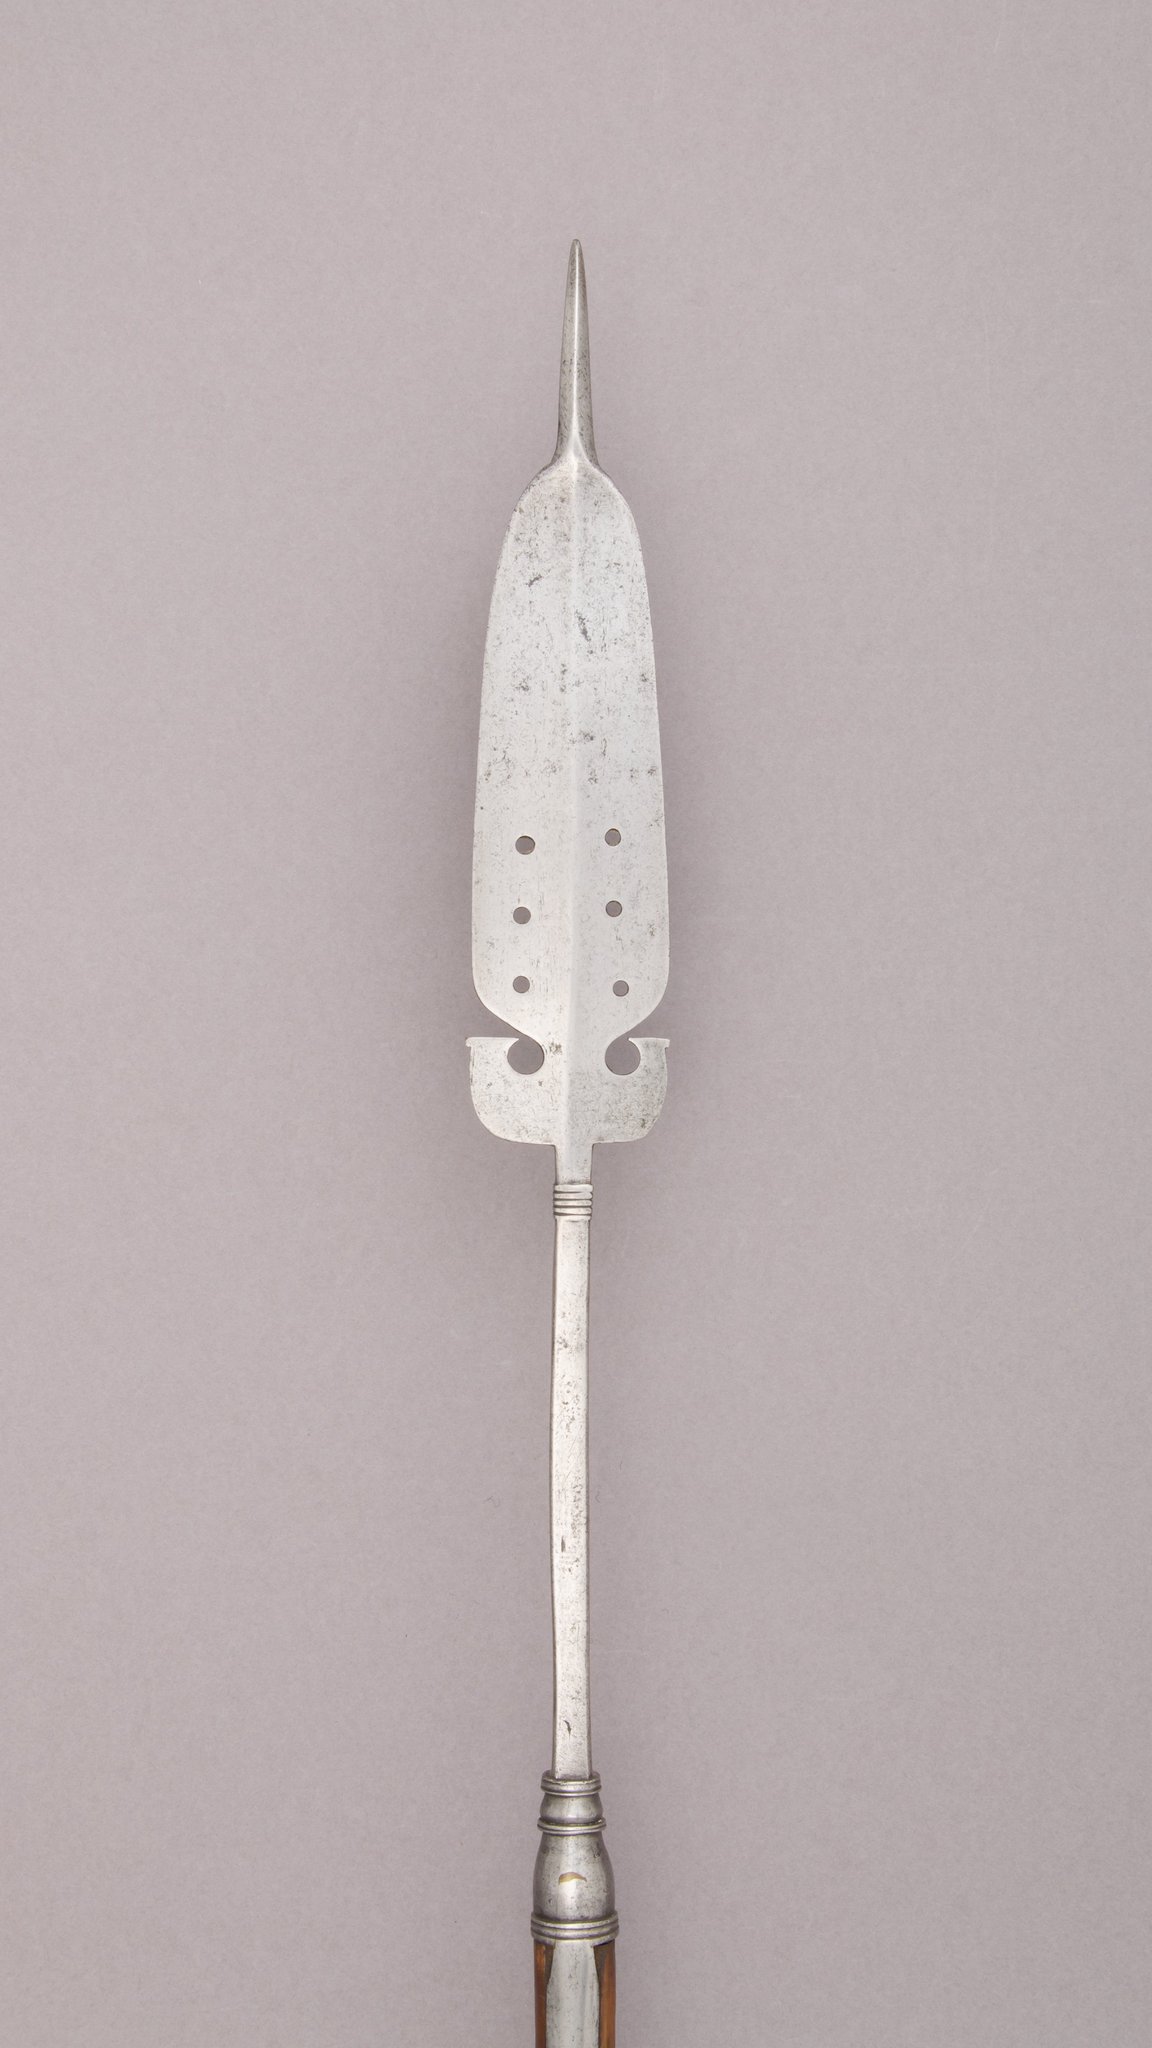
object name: halberd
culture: american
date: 1750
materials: steel, wood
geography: united states